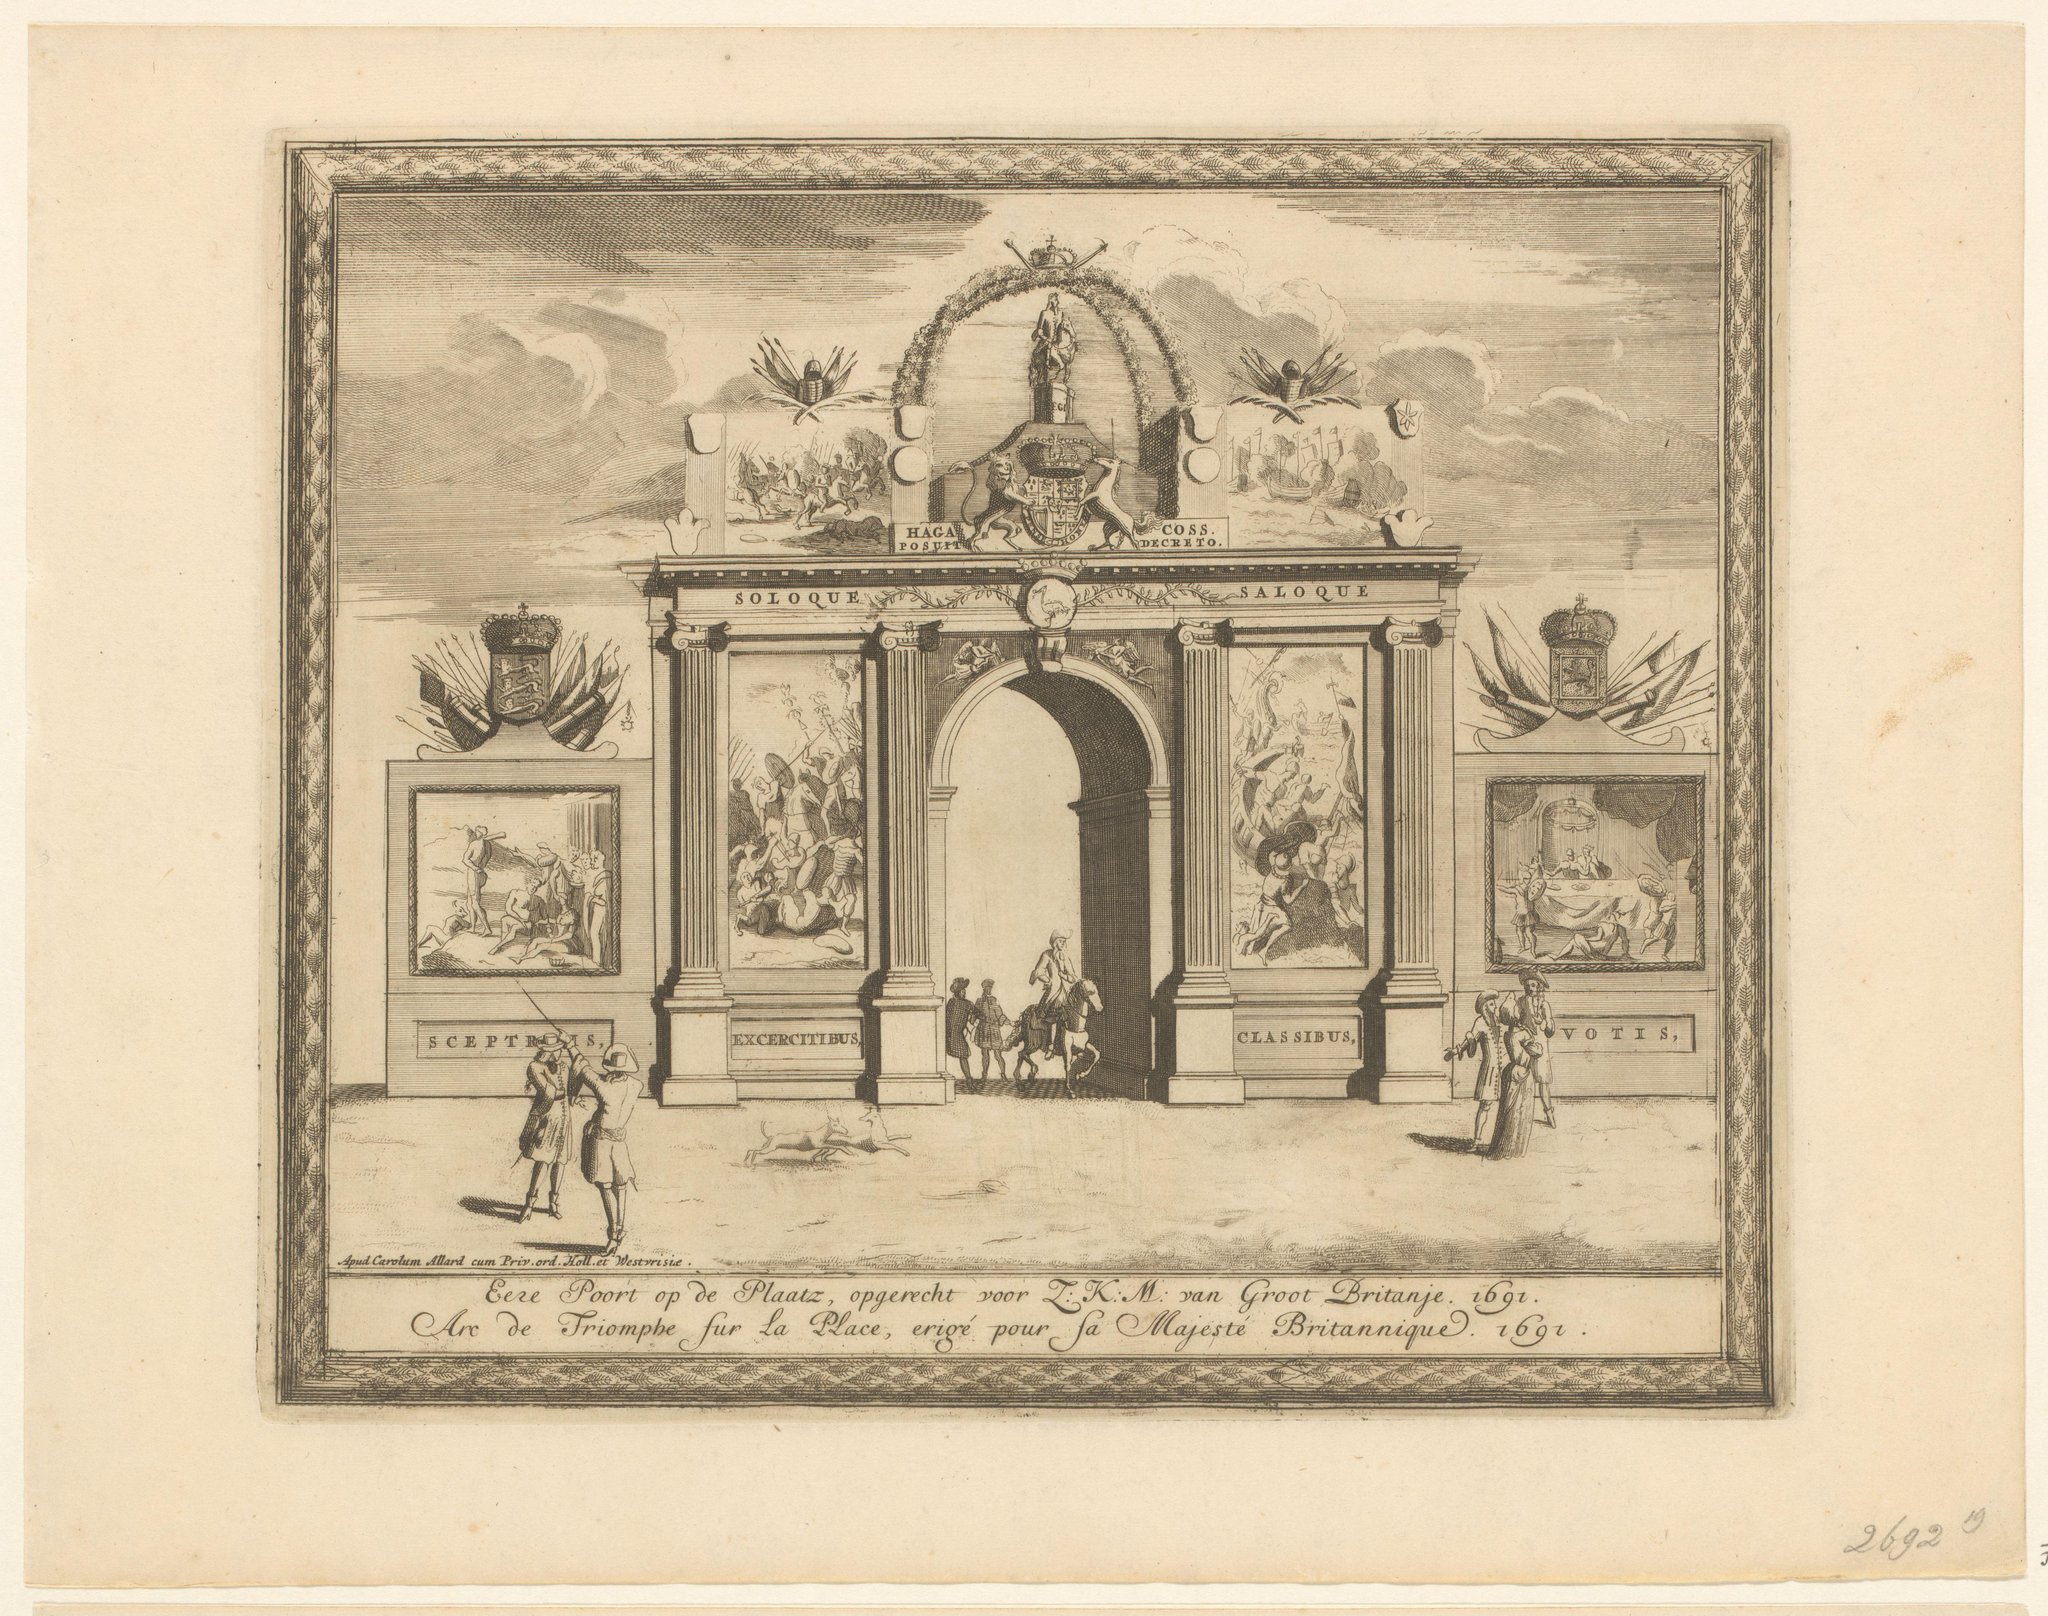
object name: print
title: Eere Poort op de Plaatz, opgerecht voor Z:K:M: van Groot Britanje. 1691 / Arc de Triomphe sur la Place, erigé pour sa Majesté Britannique 1691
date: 1691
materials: paper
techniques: etching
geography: northern netherlands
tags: william iii (prince of orange and king of england, scotland, and ireland), triumphal arch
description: Triomfpoort opgericht op de Plaats voor de intocht van koning Willem III te Den Haag, 5 februari 1691. Plaat 19 in een serie van 20 platen over de Glorious Revolution in Engeland in de jaren 1688-1691.